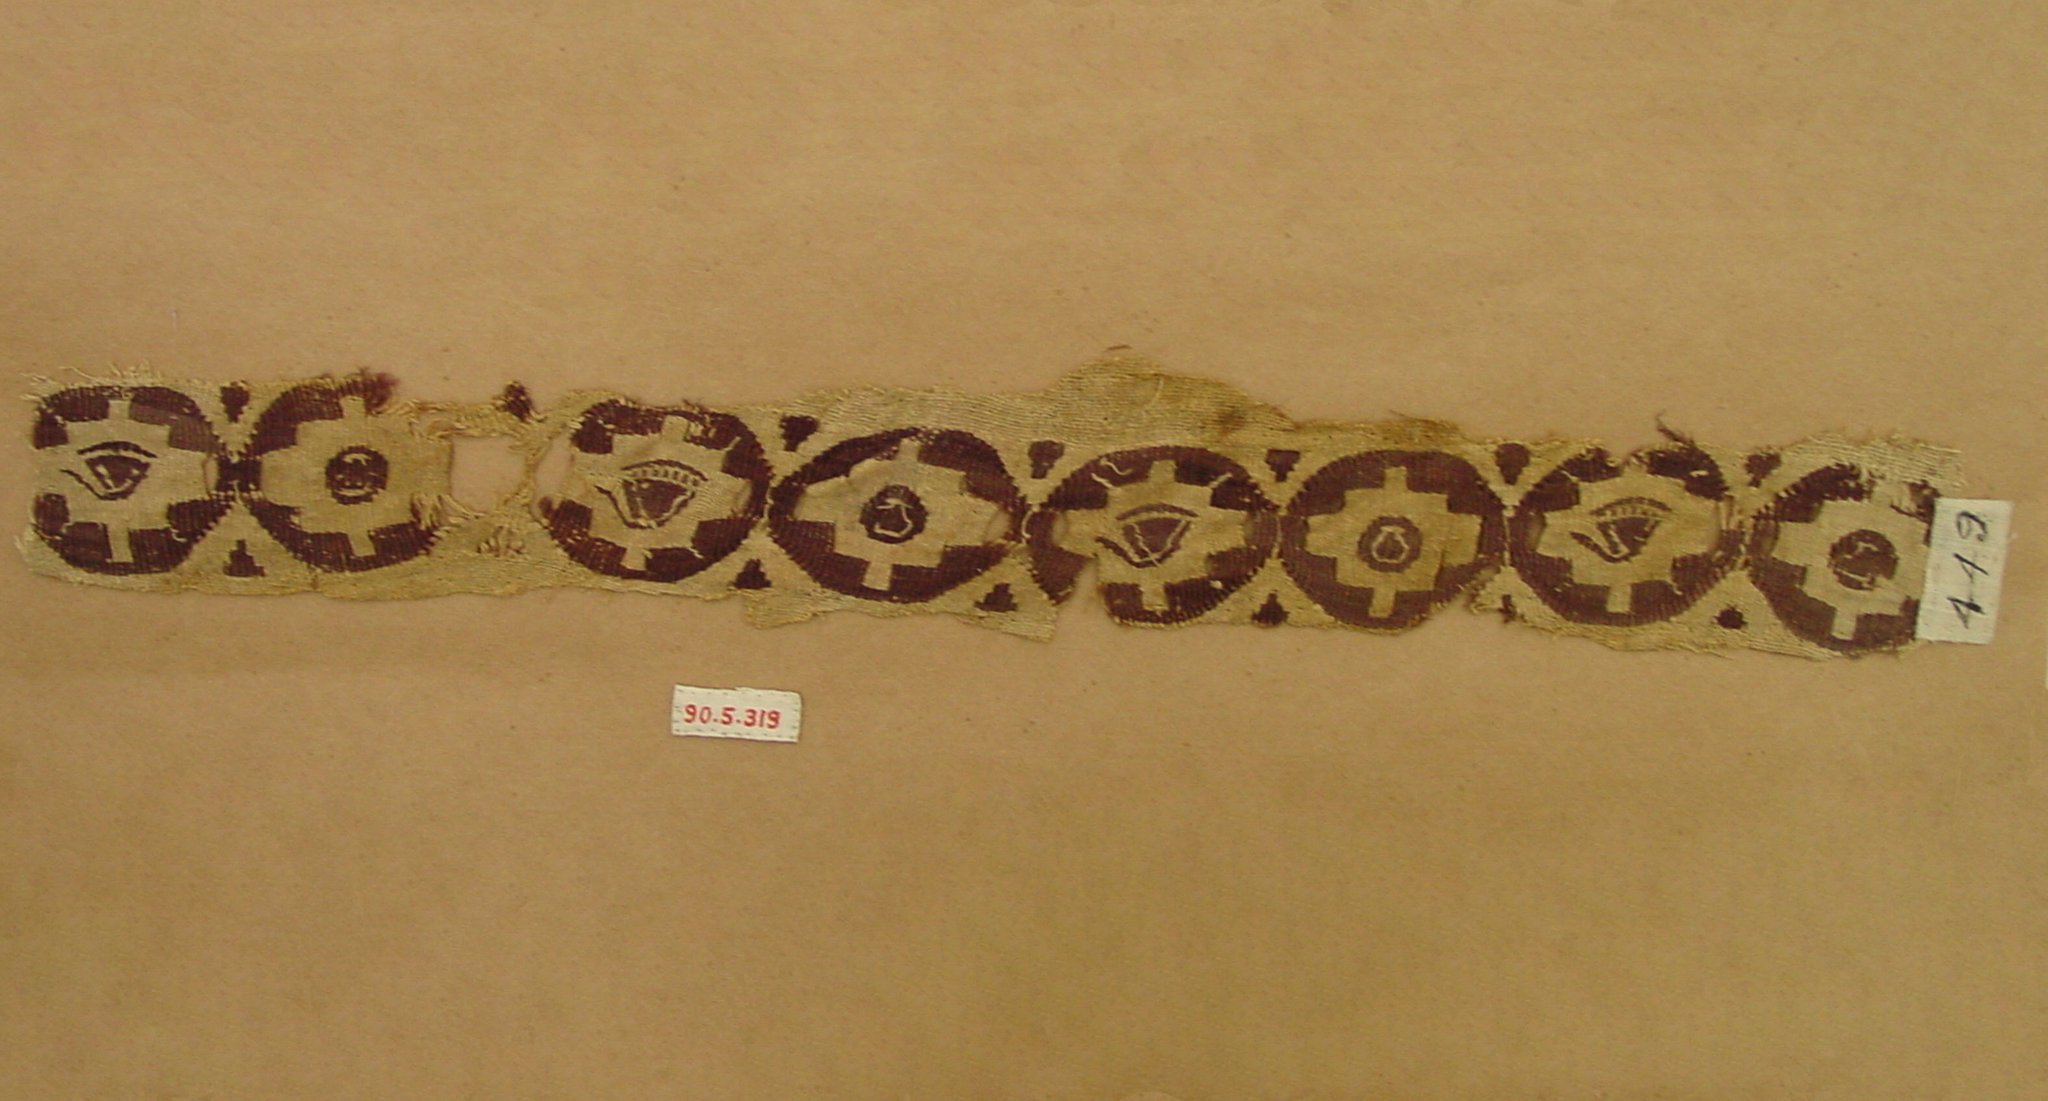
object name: textile fragment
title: Fragment of a Band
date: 201-400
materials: linen, wool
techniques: weave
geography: egypt